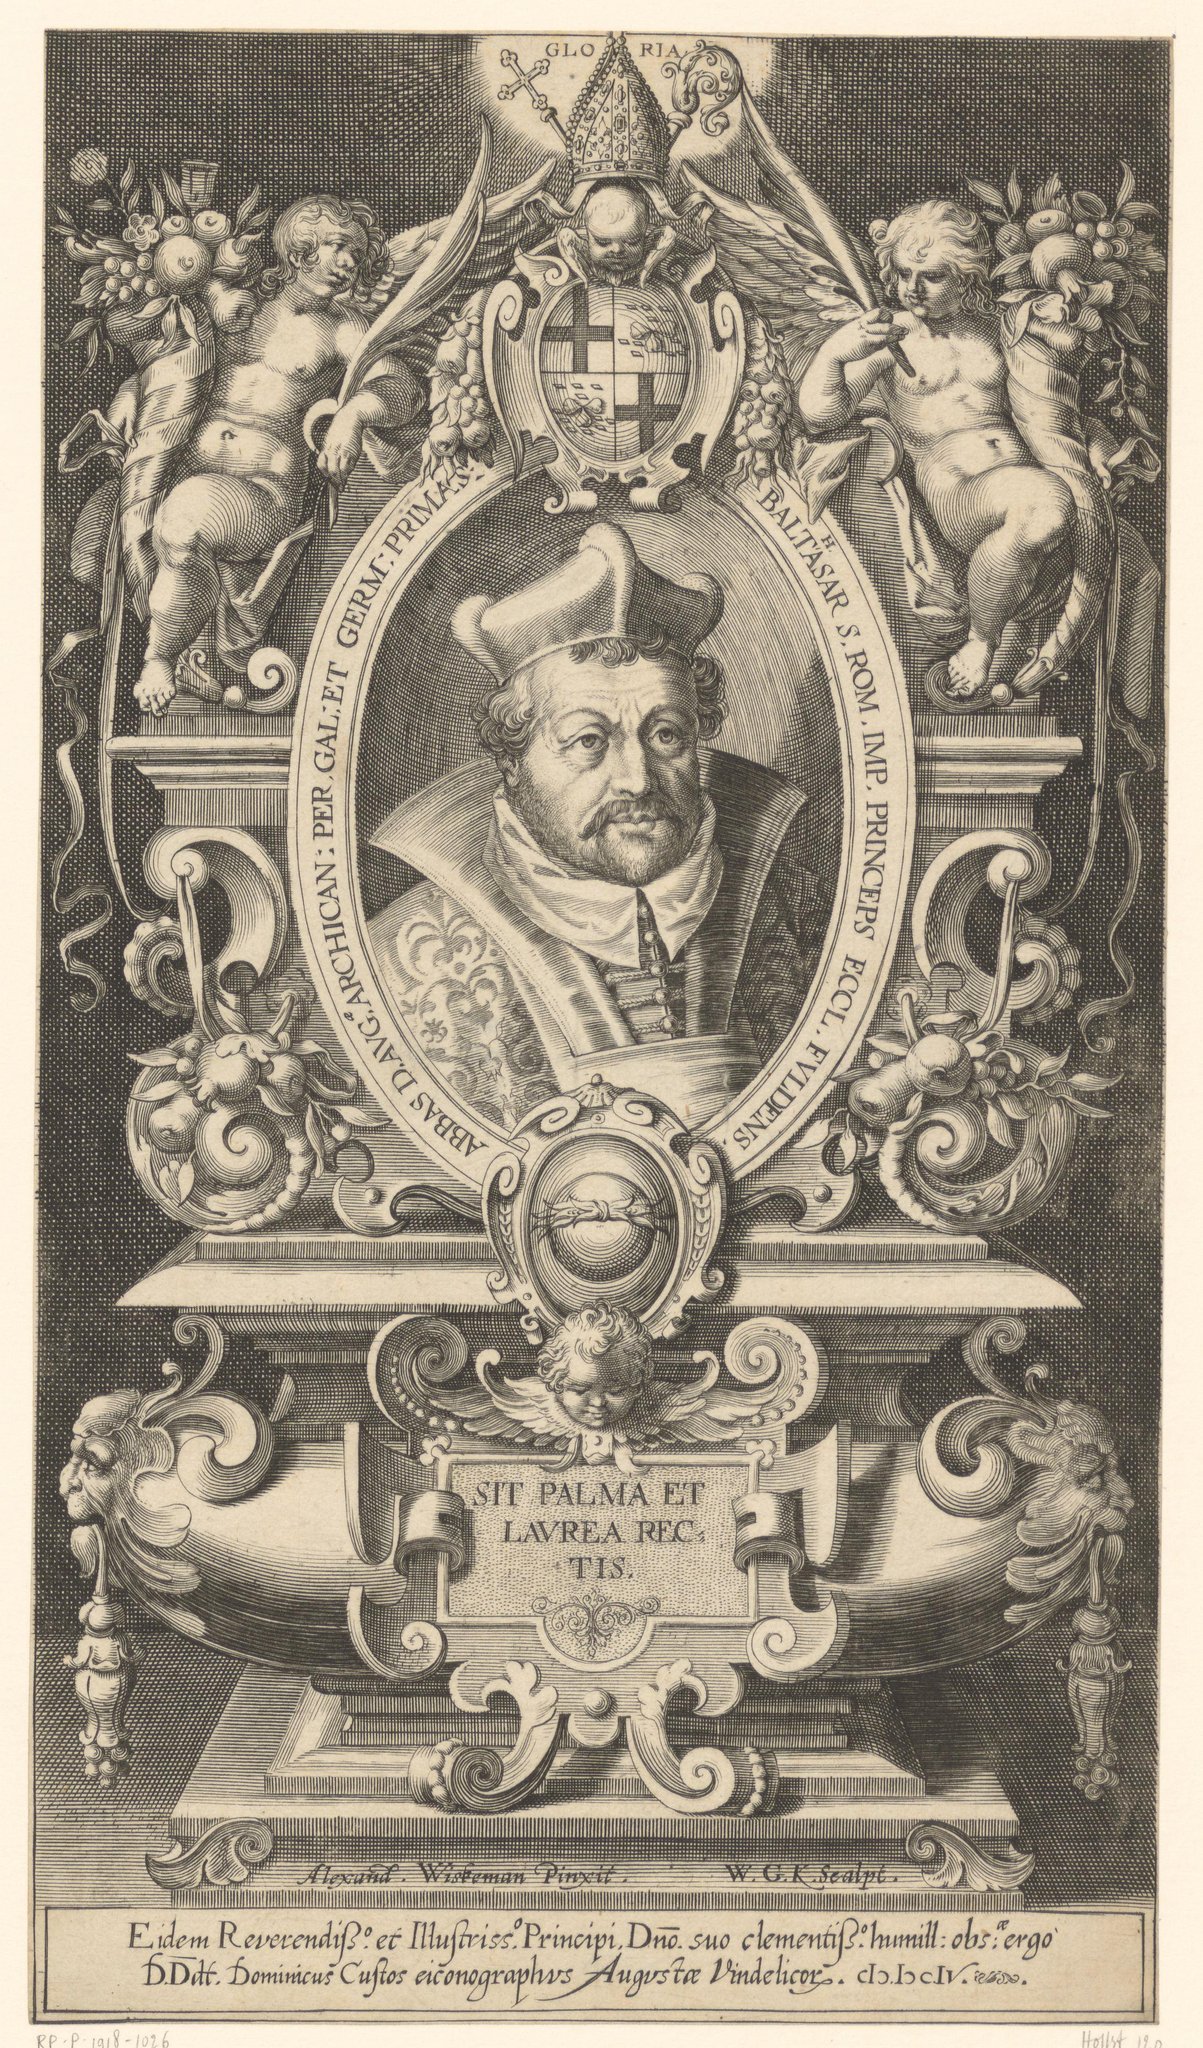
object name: print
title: Portret van Balthasar von Dernbach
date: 1604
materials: paper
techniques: engraving, etching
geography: augsburg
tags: theologian, historical persons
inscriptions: collector's mark: Lugt 2233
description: Tekst in het Latijn in de omlijsting en in de ondermarge.